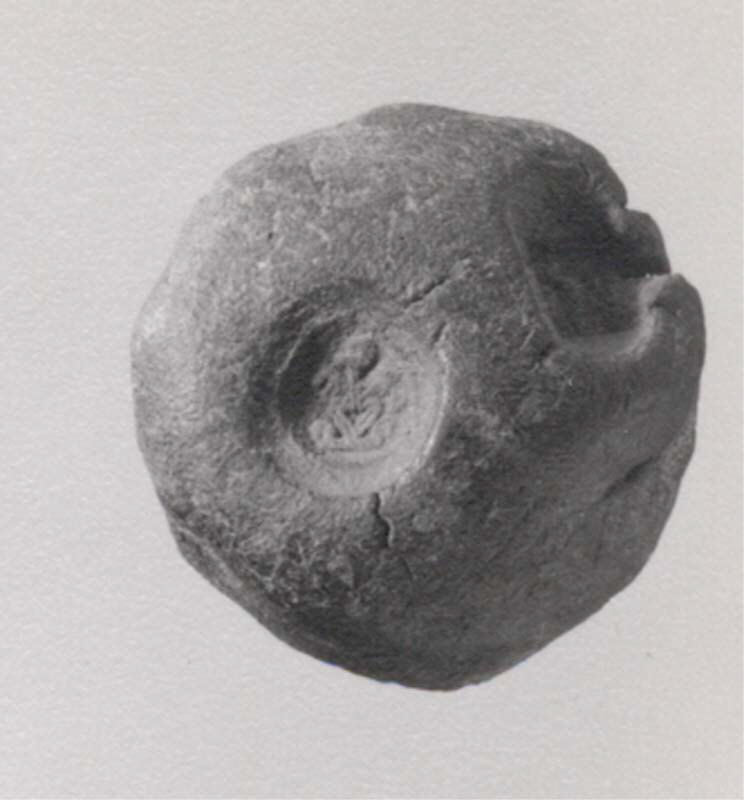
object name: sealing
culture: sasanian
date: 601-700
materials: clay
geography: iran